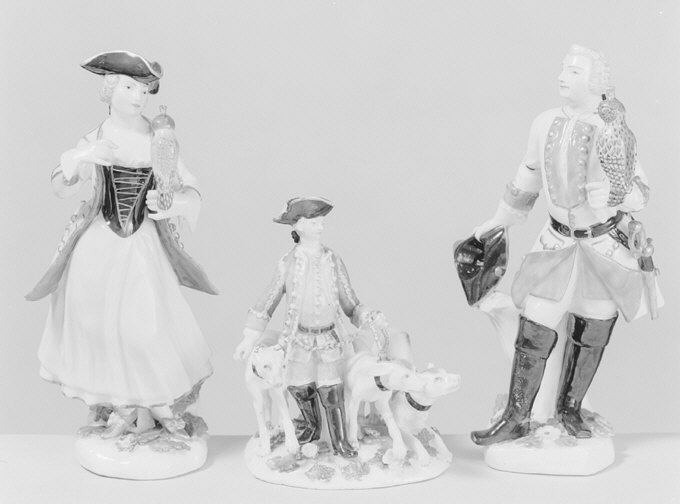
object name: figure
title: Hunter leading hounds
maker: meissen manufactory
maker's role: manufactory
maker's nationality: german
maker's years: 1710-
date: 1750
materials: hard paste porcelain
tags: men,women,dogs